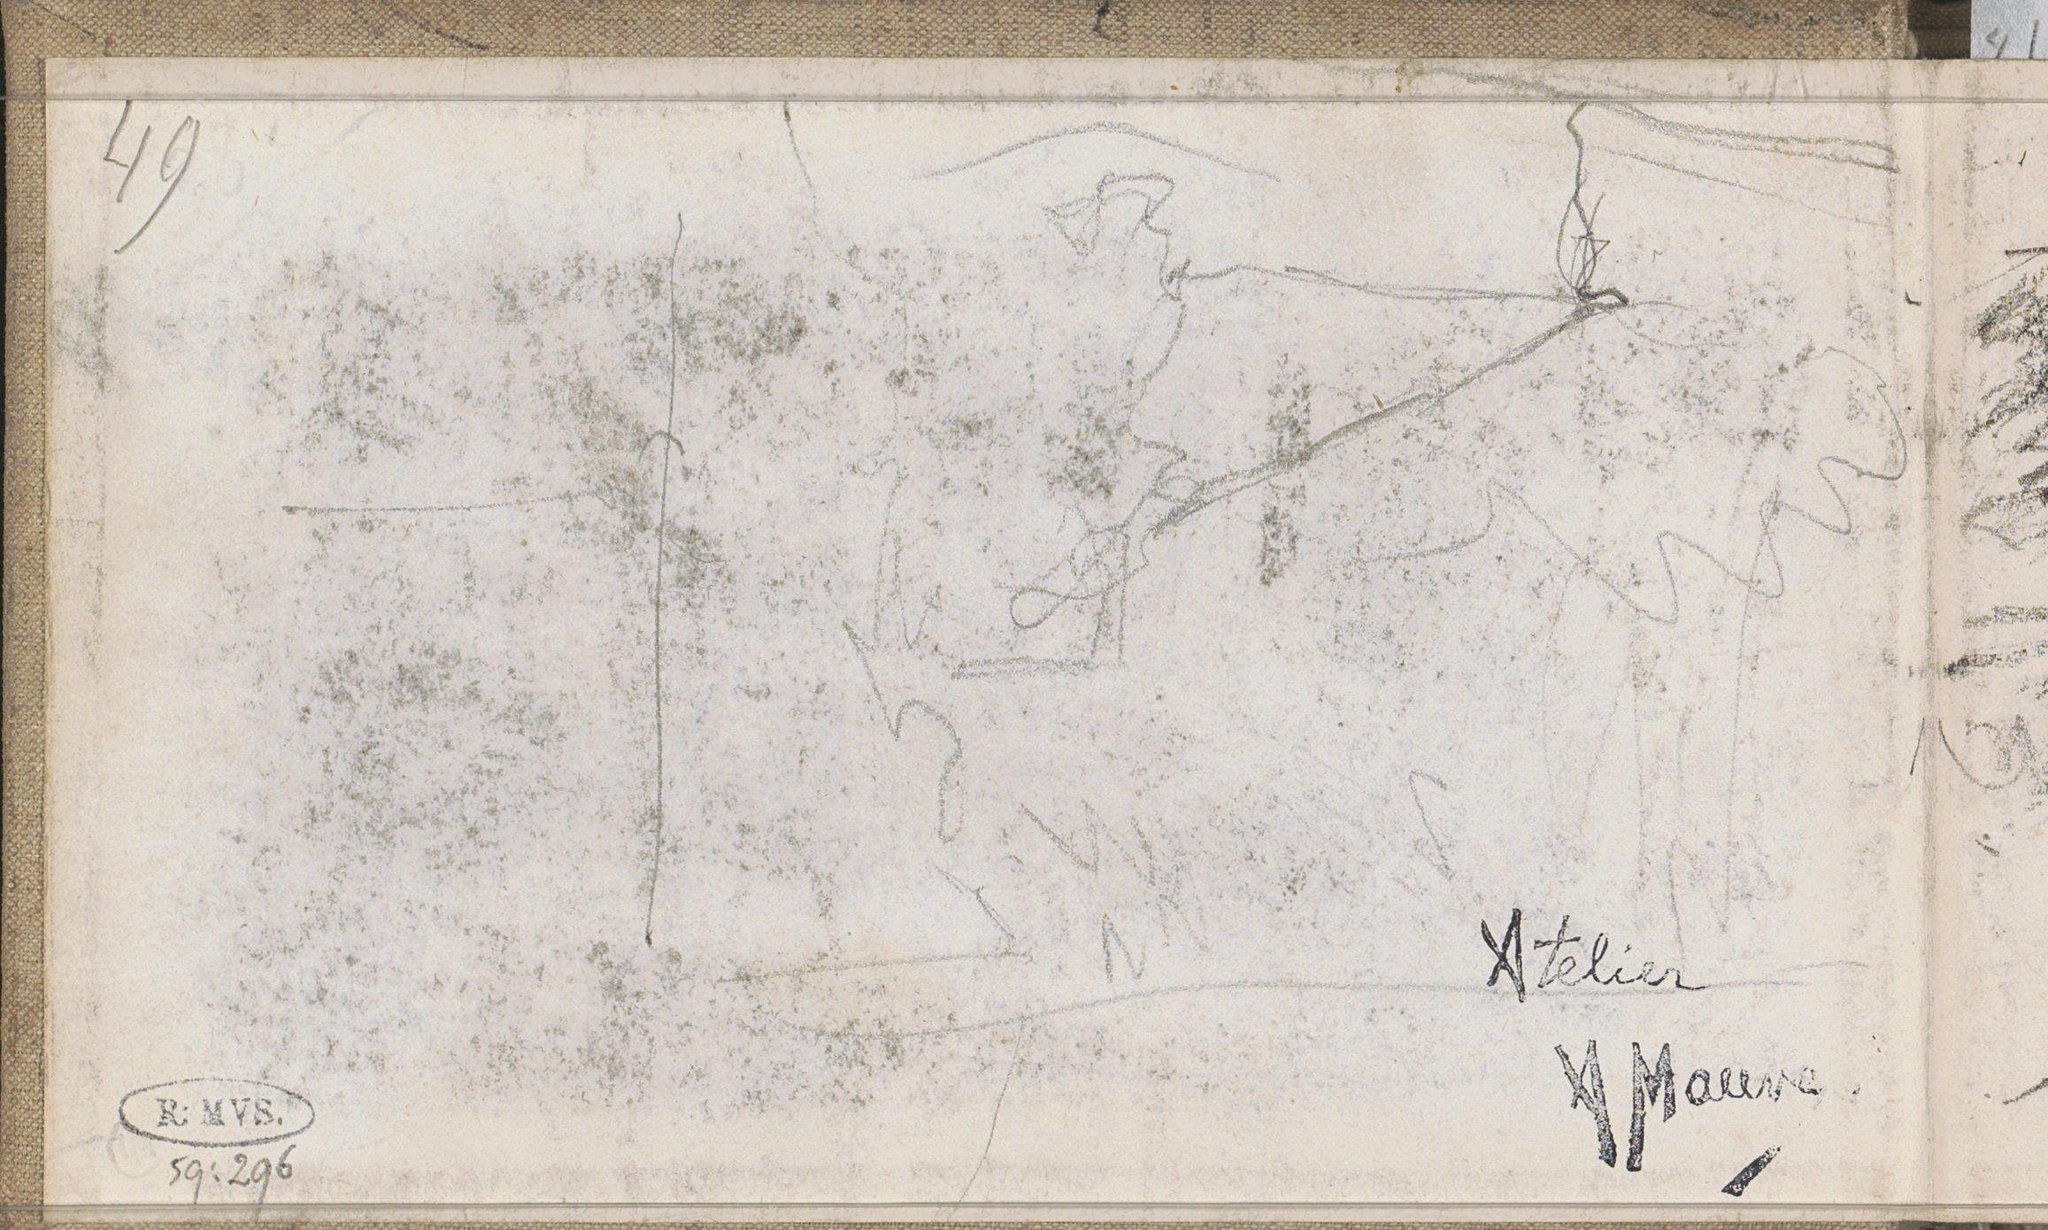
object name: sketchbook leaf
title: Studies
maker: anton mauve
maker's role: draughtsman, painter, print maker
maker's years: 1838-1888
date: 1848-1888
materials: paper, pencil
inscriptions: number: ‘49’, collector's mark: Lugt 2228a, workshop stamp: ‘Atelier/ A Mauve’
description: Voorste schutblad uit een schetsboek met 43 bladen.